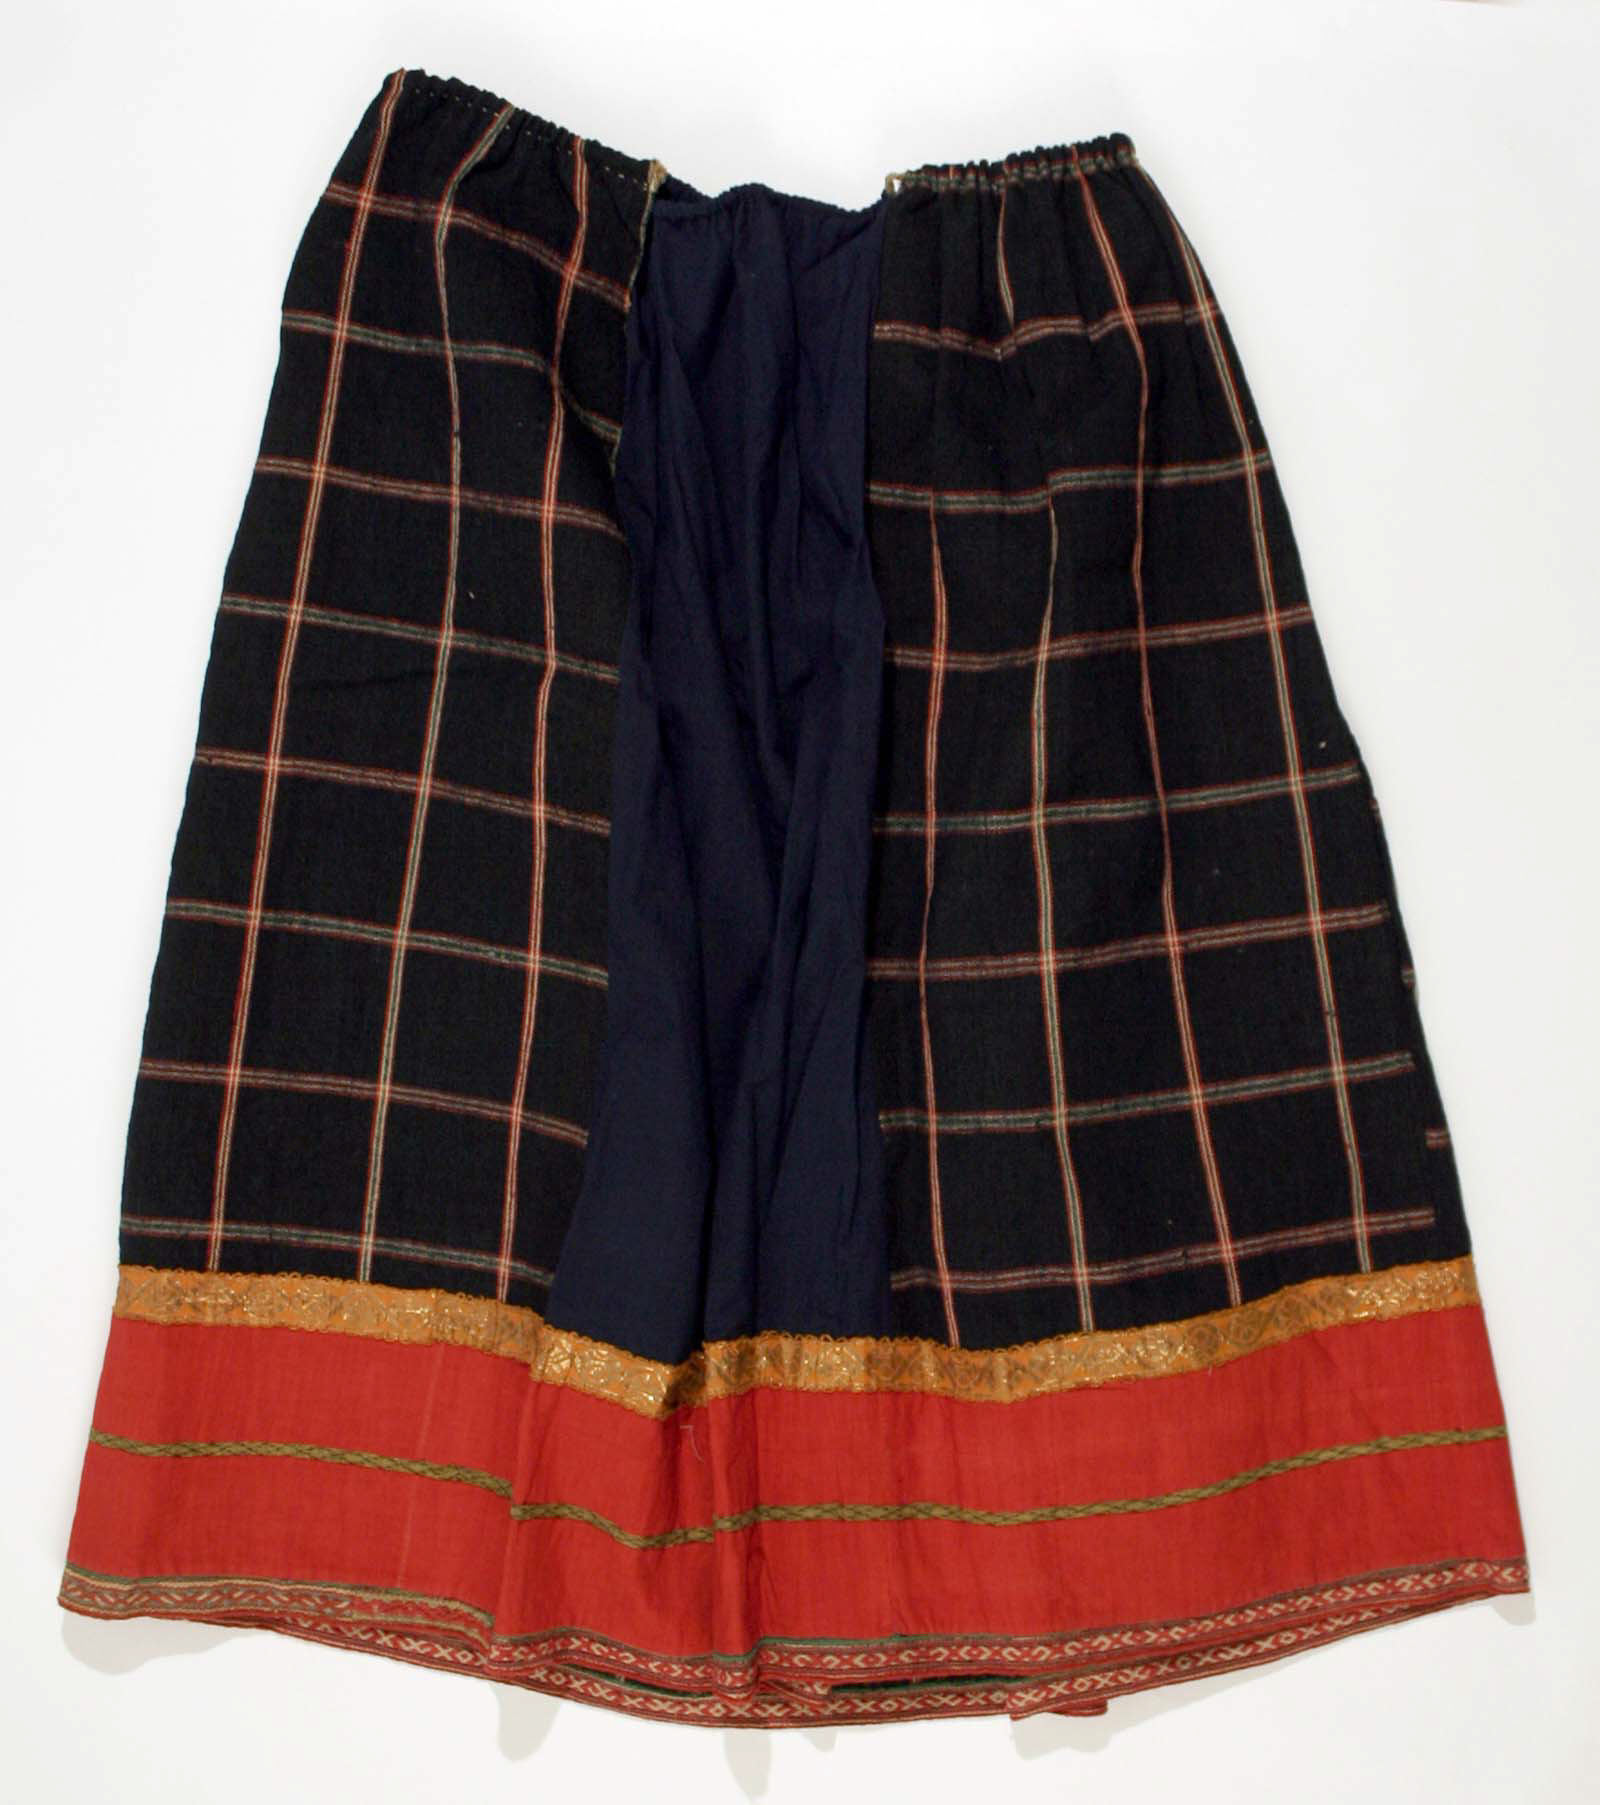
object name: skirt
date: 1801-1900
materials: wool